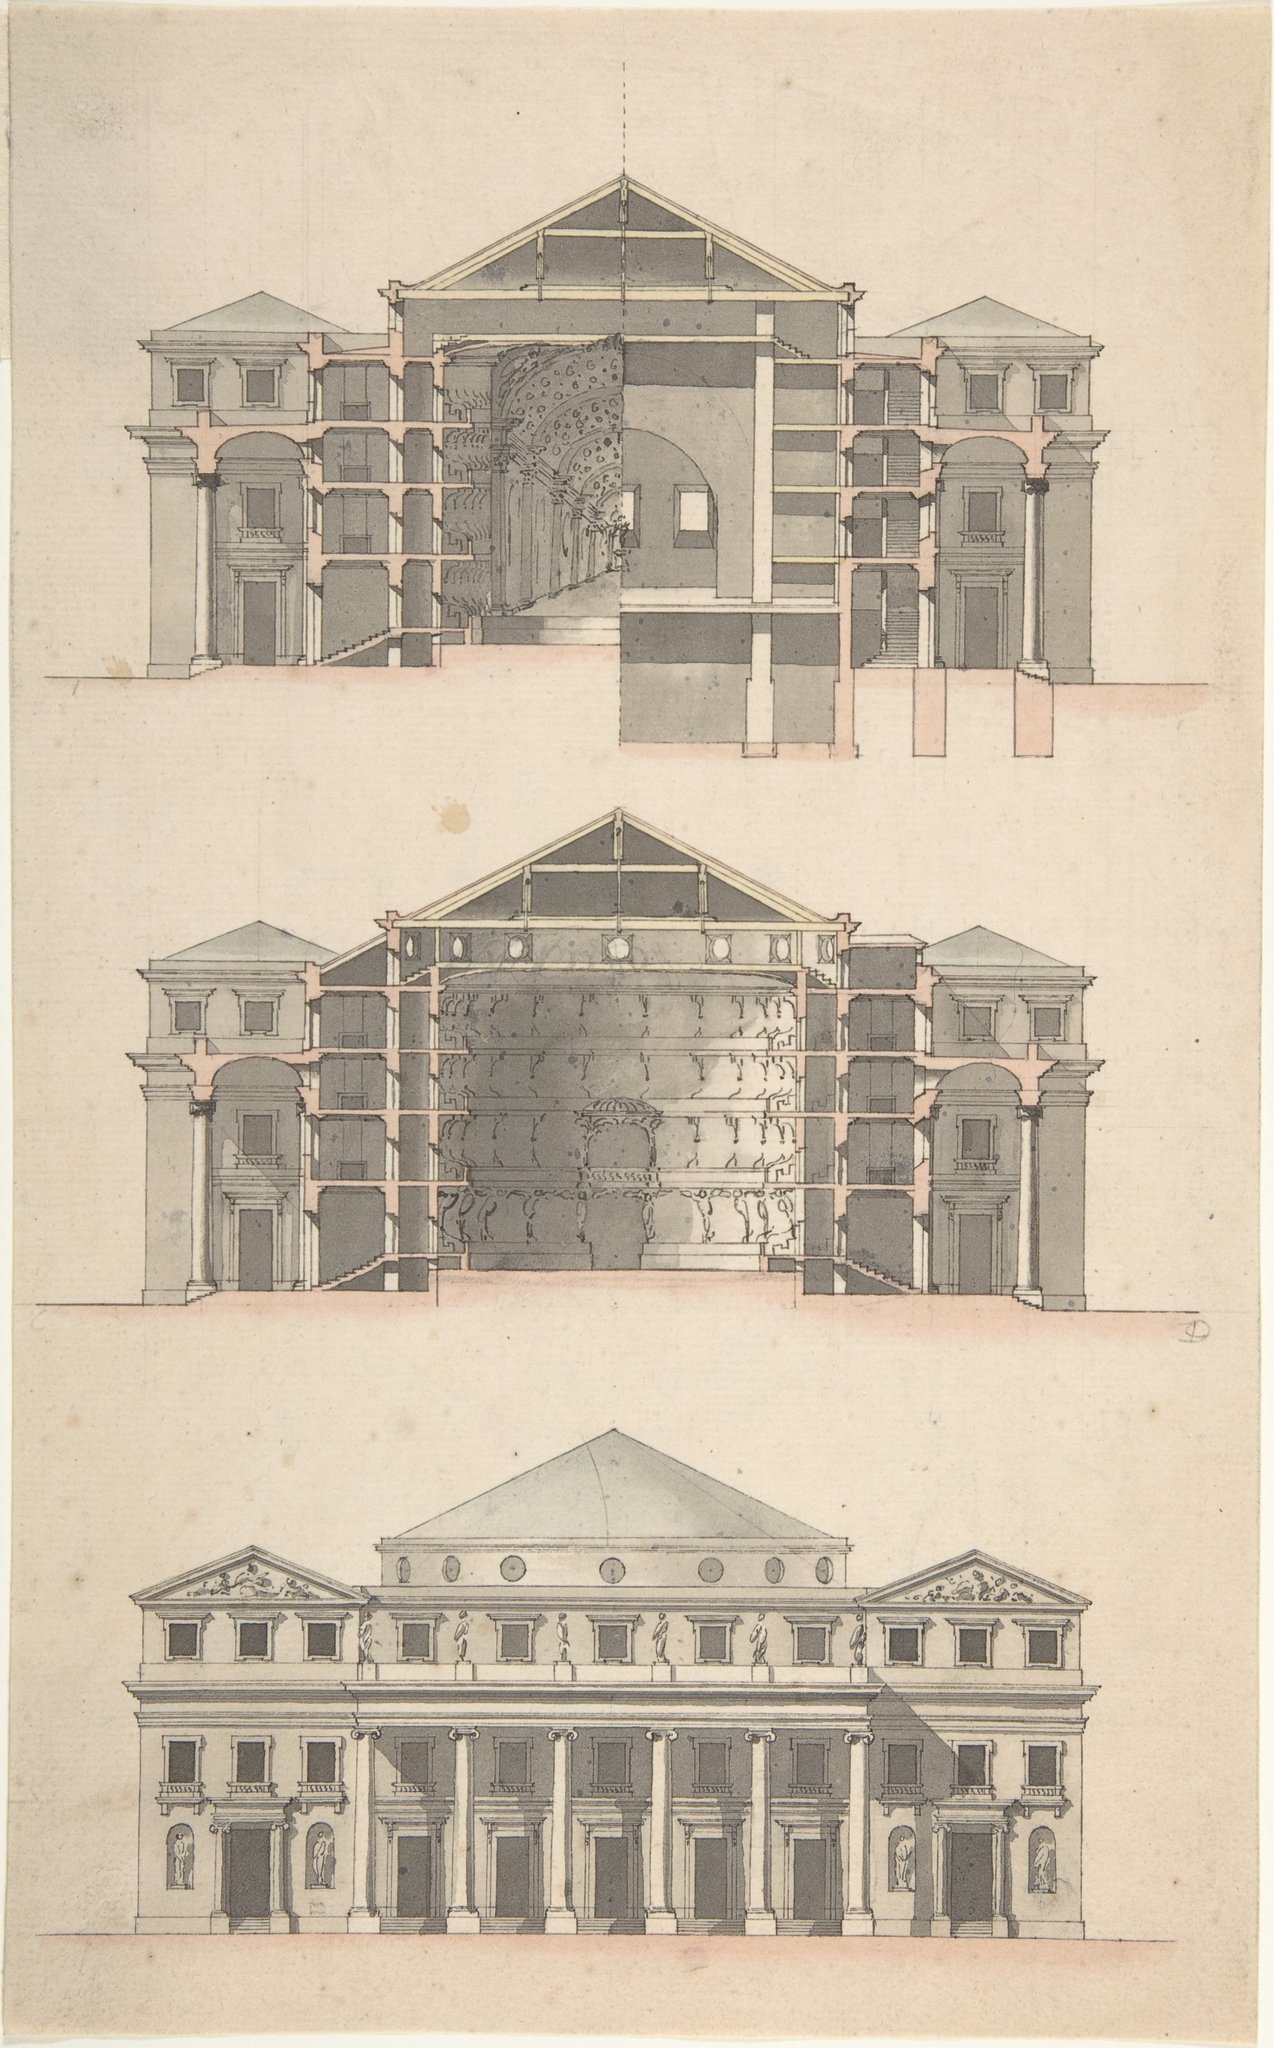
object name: drawing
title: Design for a Theatre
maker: anonymous, french, 18th century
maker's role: artist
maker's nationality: french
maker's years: 1700-1800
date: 1701-1800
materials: graphite, ink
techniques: brush, pen, wash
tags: theatre,architecture